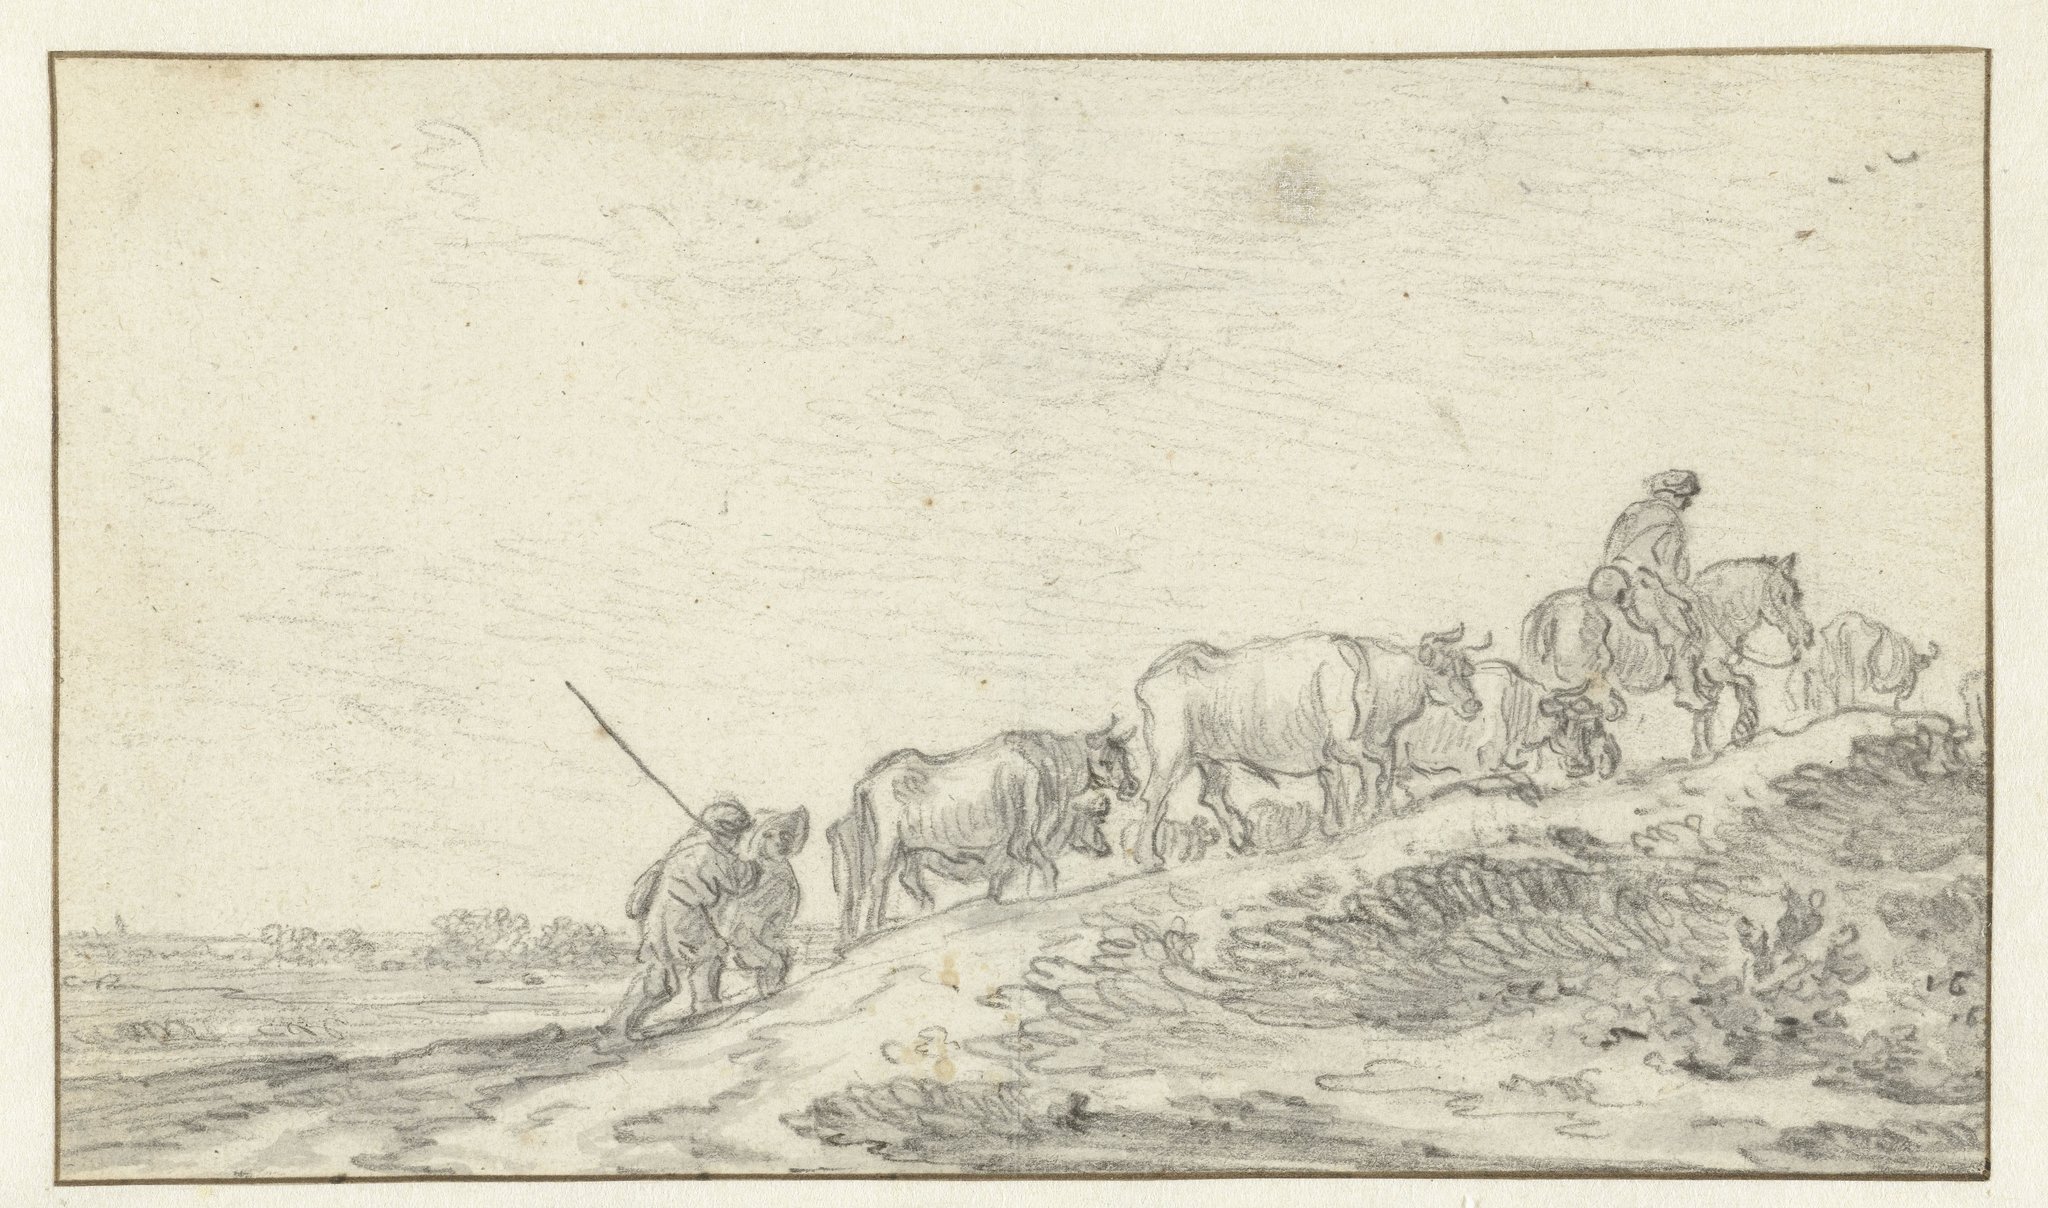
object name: drawing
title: Veedrijvers en vee op een helling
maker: jan van goyen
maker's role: draughtsman, painter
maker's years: 1596-1656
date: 1630-1633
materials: chalk, paper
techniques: brush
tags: cattle driving, cattle driver